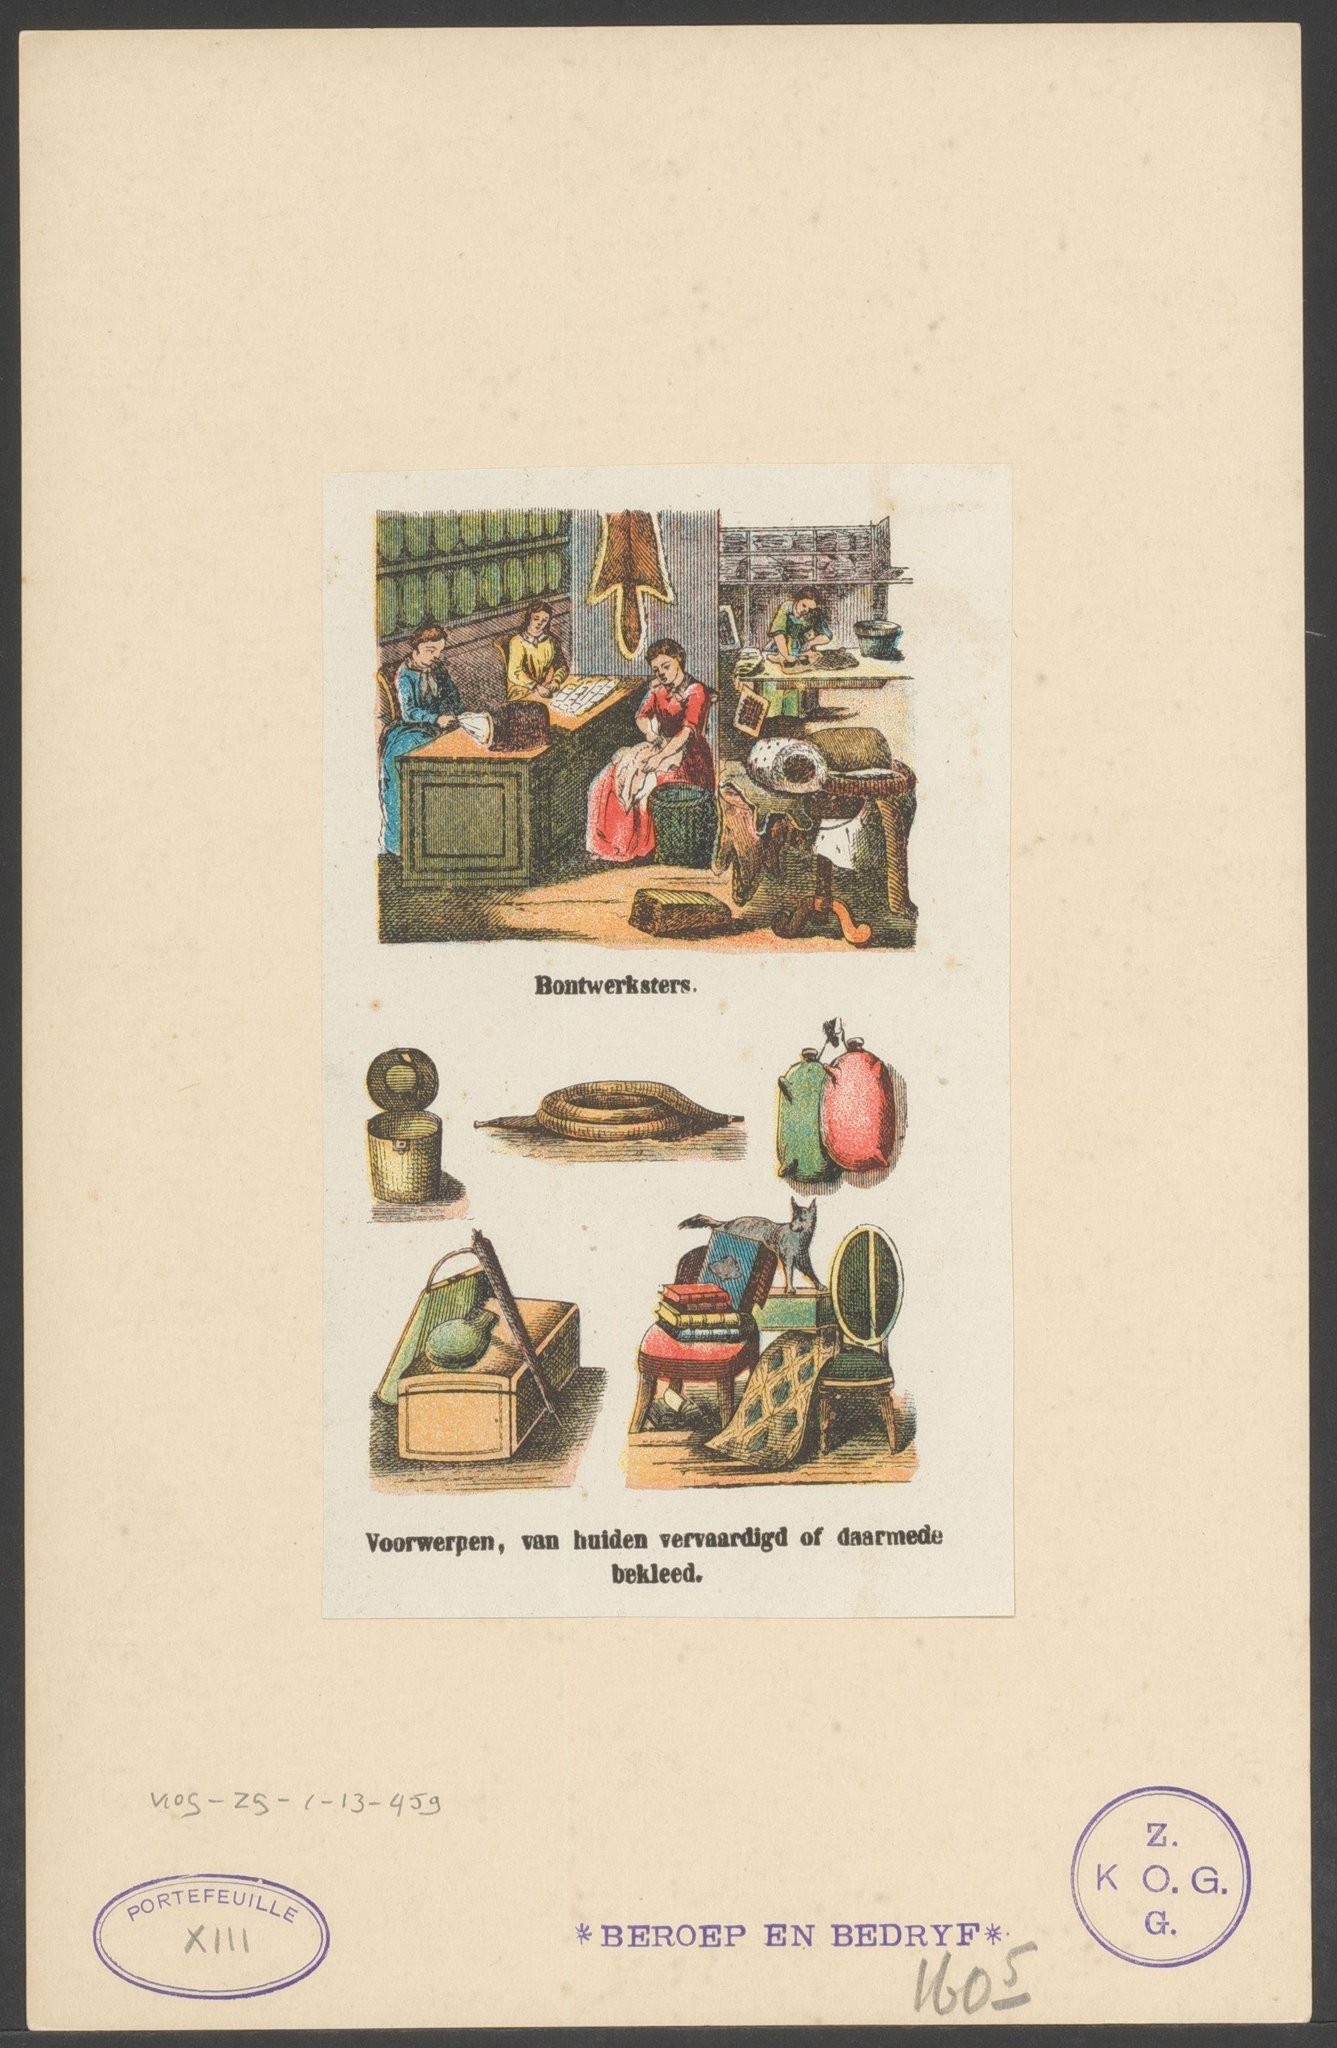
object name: print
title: Bontwerkster en voorwerpen van huiden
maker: Anonymous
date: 1870-1880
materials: paper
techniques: lithograph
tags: furrier, handicrafts ~ animal material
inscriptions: stamp, stamp, collector's mark: Lugt 1641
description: Onderwerpsrubrieken binnen de Atlas Zeden en Gewoonten: Handel, Nijverheid en verkeer, Beroep en bedrijf, Mannelijk, Bewerkers van het leder.